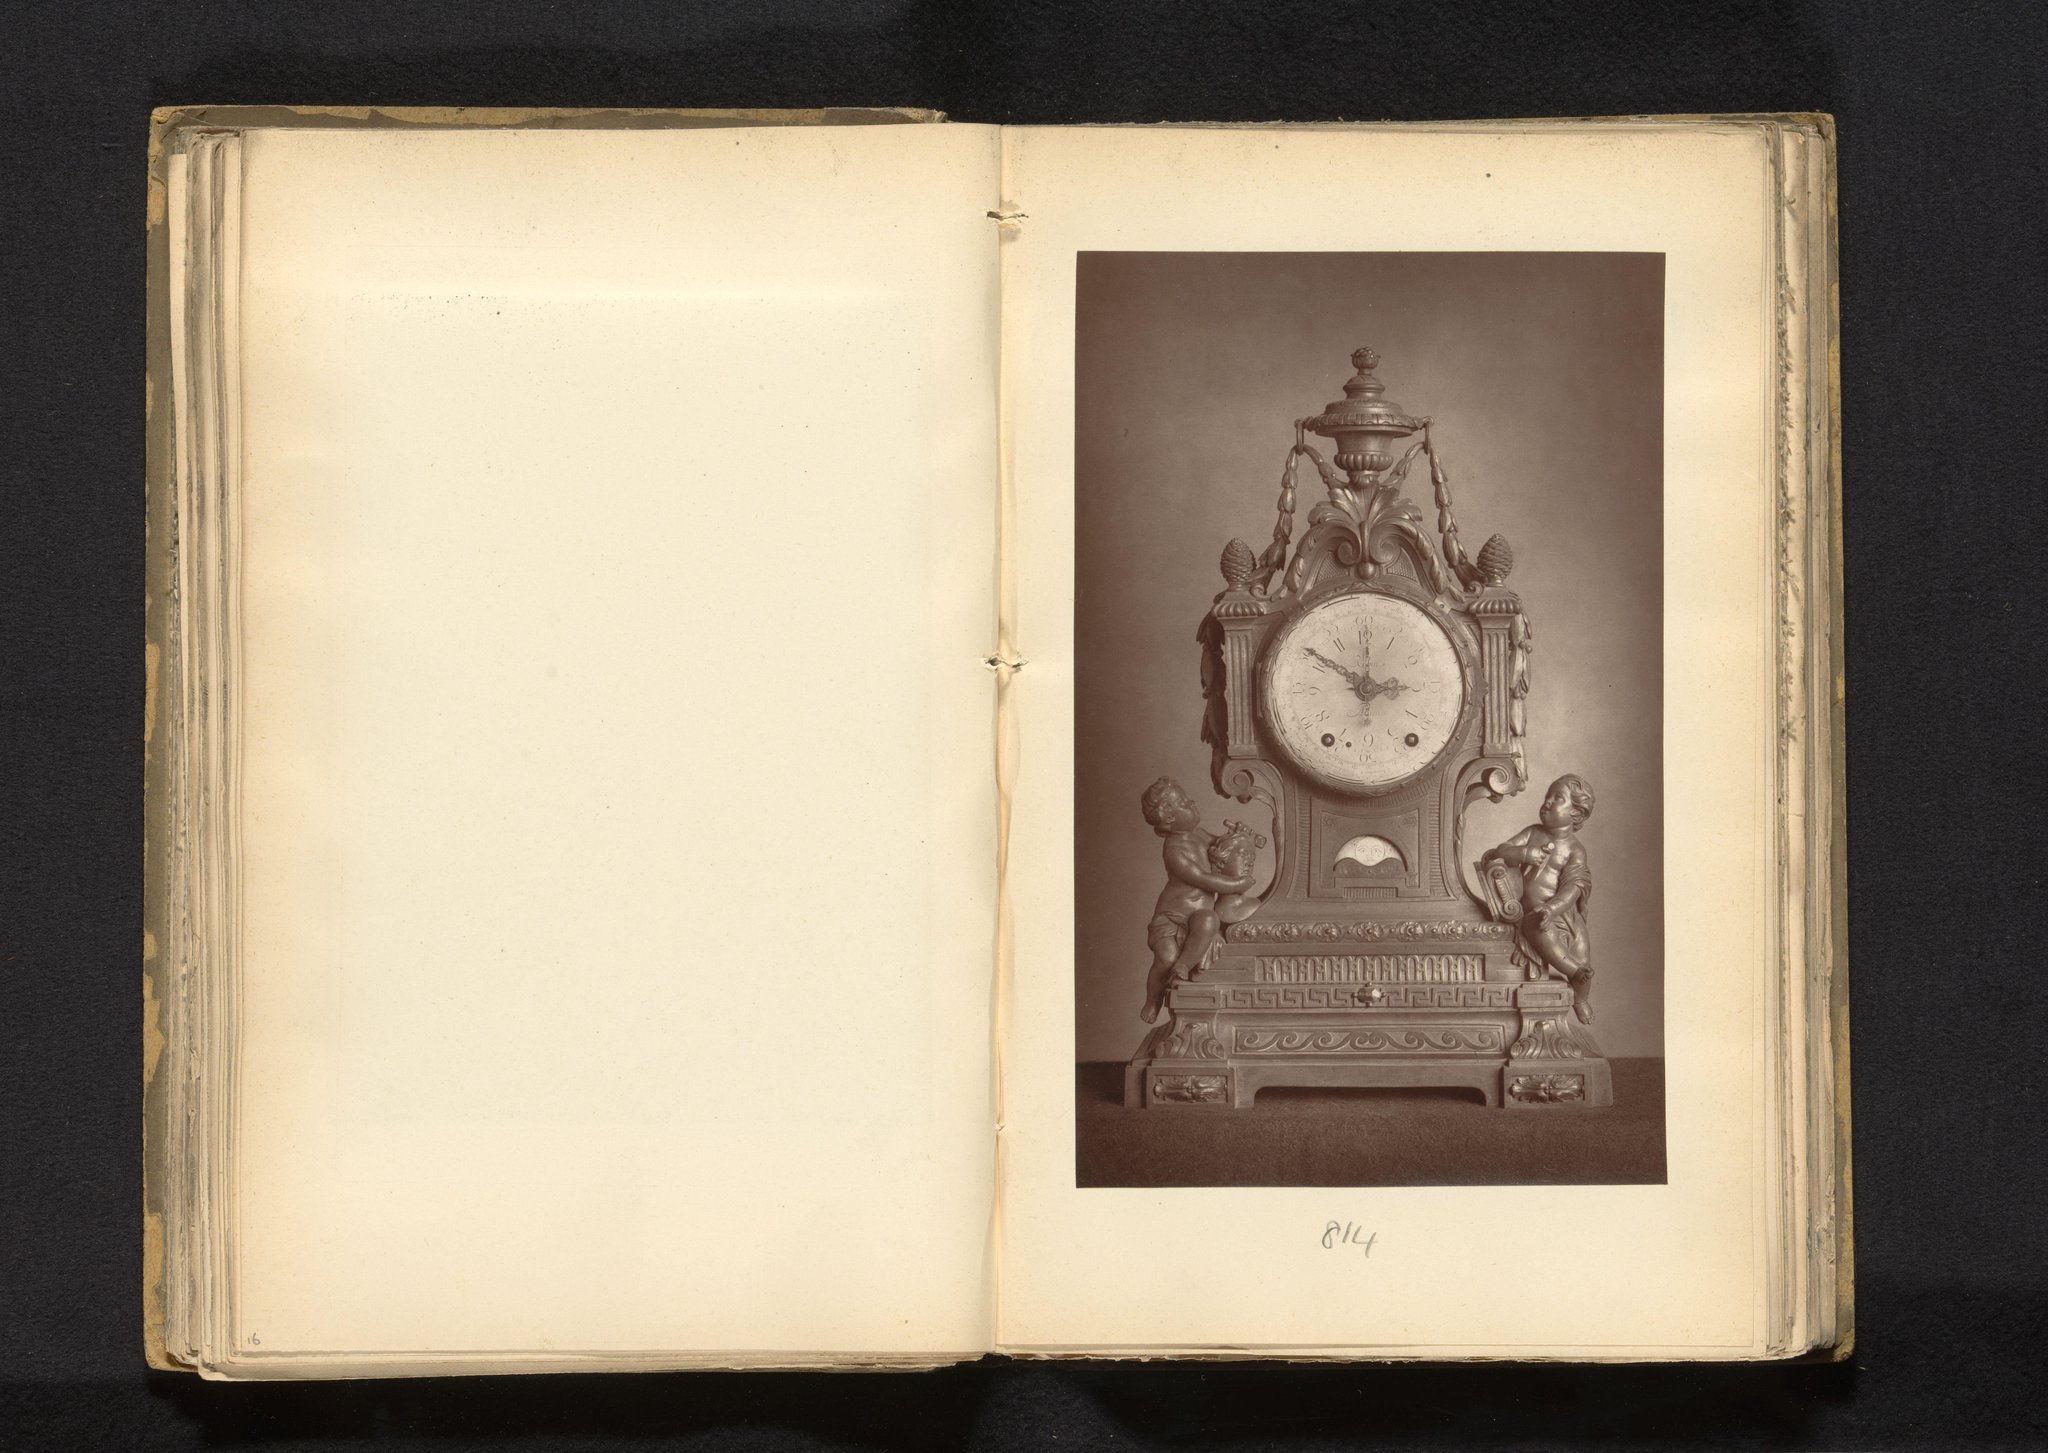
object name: photomechanical print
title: Klok in de stijl van Lodewijk XVI, uit de collectie van Christopher Beckett Denison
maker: Anonymous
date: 1880-1885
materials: paper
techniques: woodburytype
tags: clock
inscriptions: number: ‘814’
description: Prent op zevende ongenummerde pagina na pagina 80.